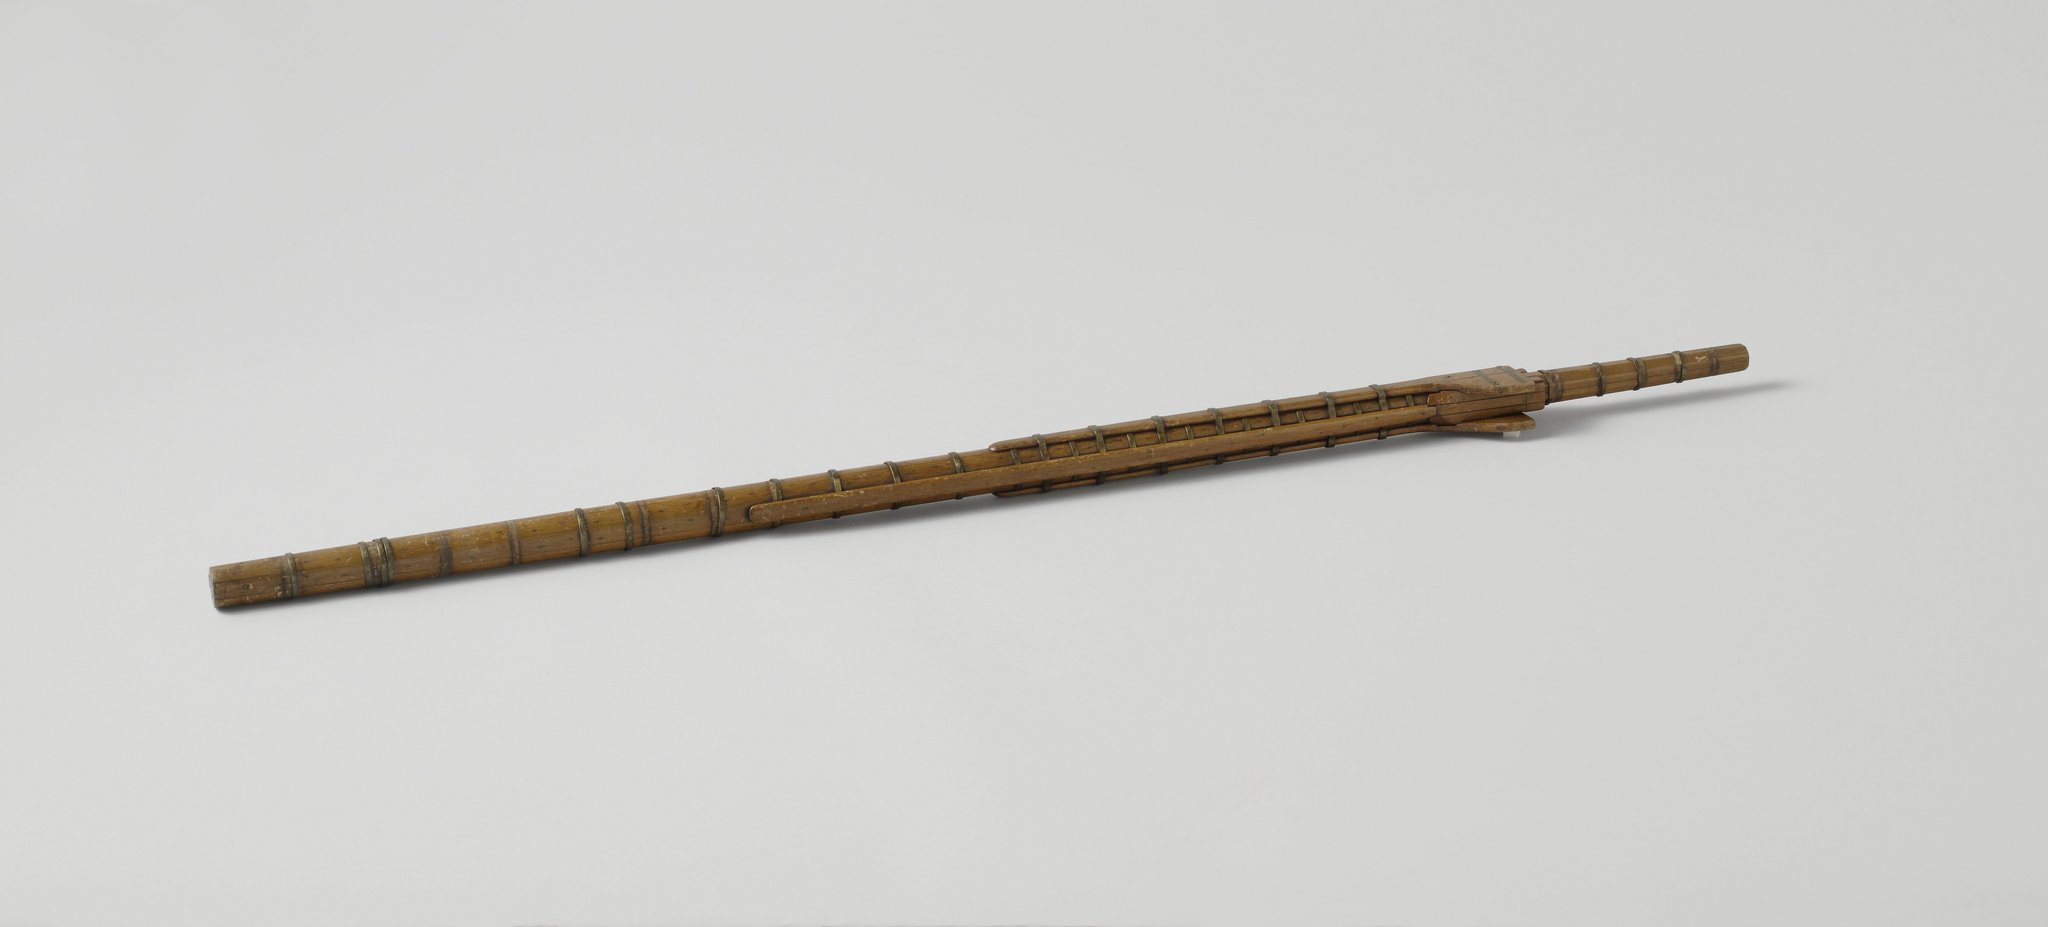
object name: demonstration model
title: Model of a Made Mast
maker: Anonymous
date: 1819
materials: brass, wood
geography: netherlands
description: Dit model stelt de grote mast van het linieschip van 74 stukken Willem de Eerste voor (Pieter van Zwijndregt Pzn., Rotterdam 1782-1785, hernoemd Brutus in 1795, hernoemd Braband in 1806, gesloopt in 1820); deze mast werd in 1819 afgekeurd en vervangen door de mast voorgesteld door NG-MC-138-2.